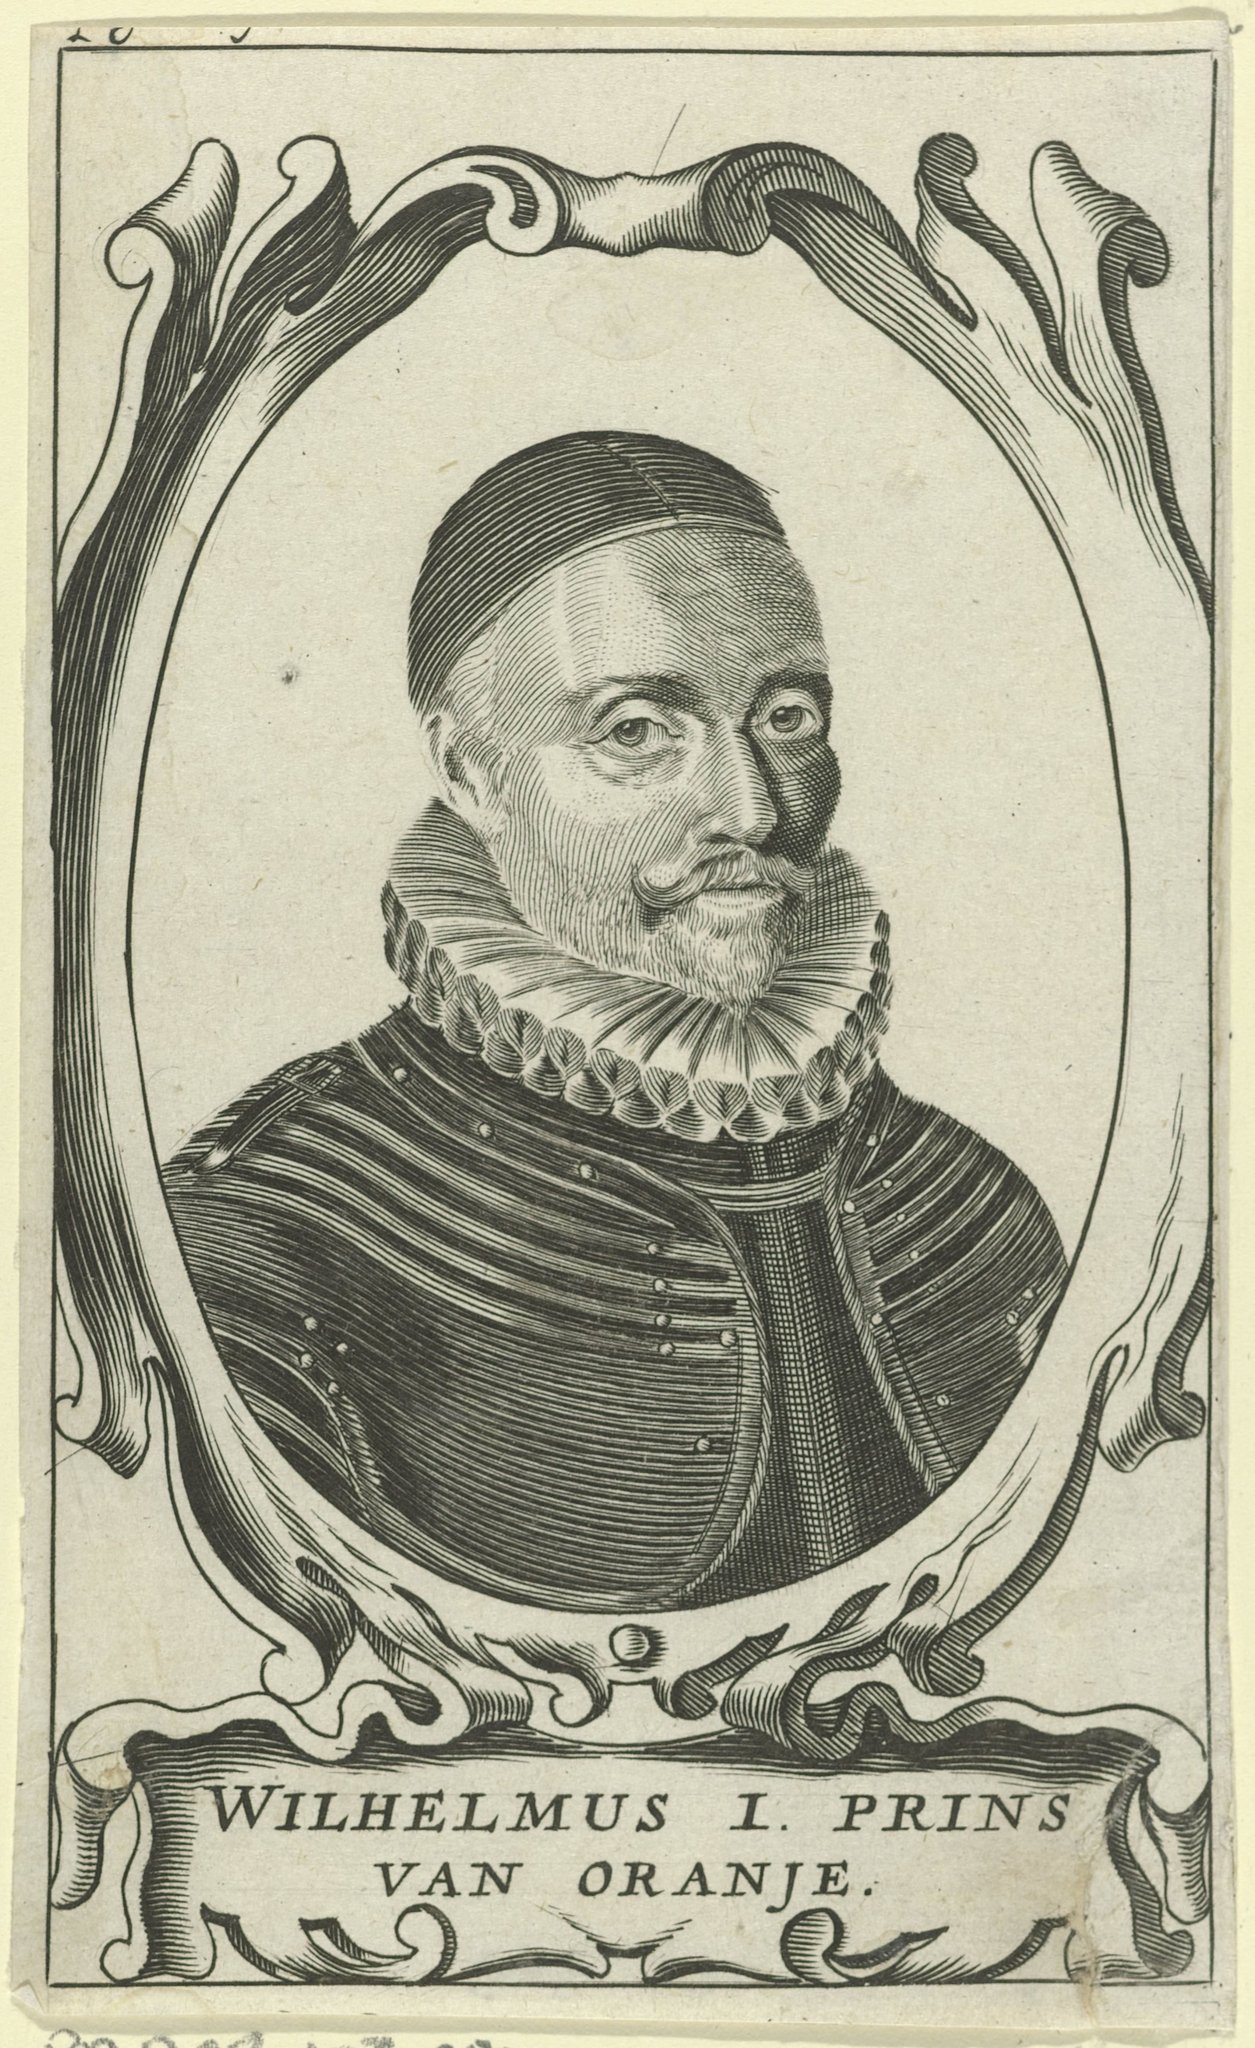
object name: print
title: Portret van Willem I, prins van Oranje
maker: Anonymous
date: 1663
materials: paper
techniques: engraving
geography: low countries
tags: william i (prince of orange)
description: De hier vermelde titel verwijst naar de hoogst verkregen titel van de geportretteerde, niet per se naar de titel die de geportretteerde op deze voorstelling draagt.